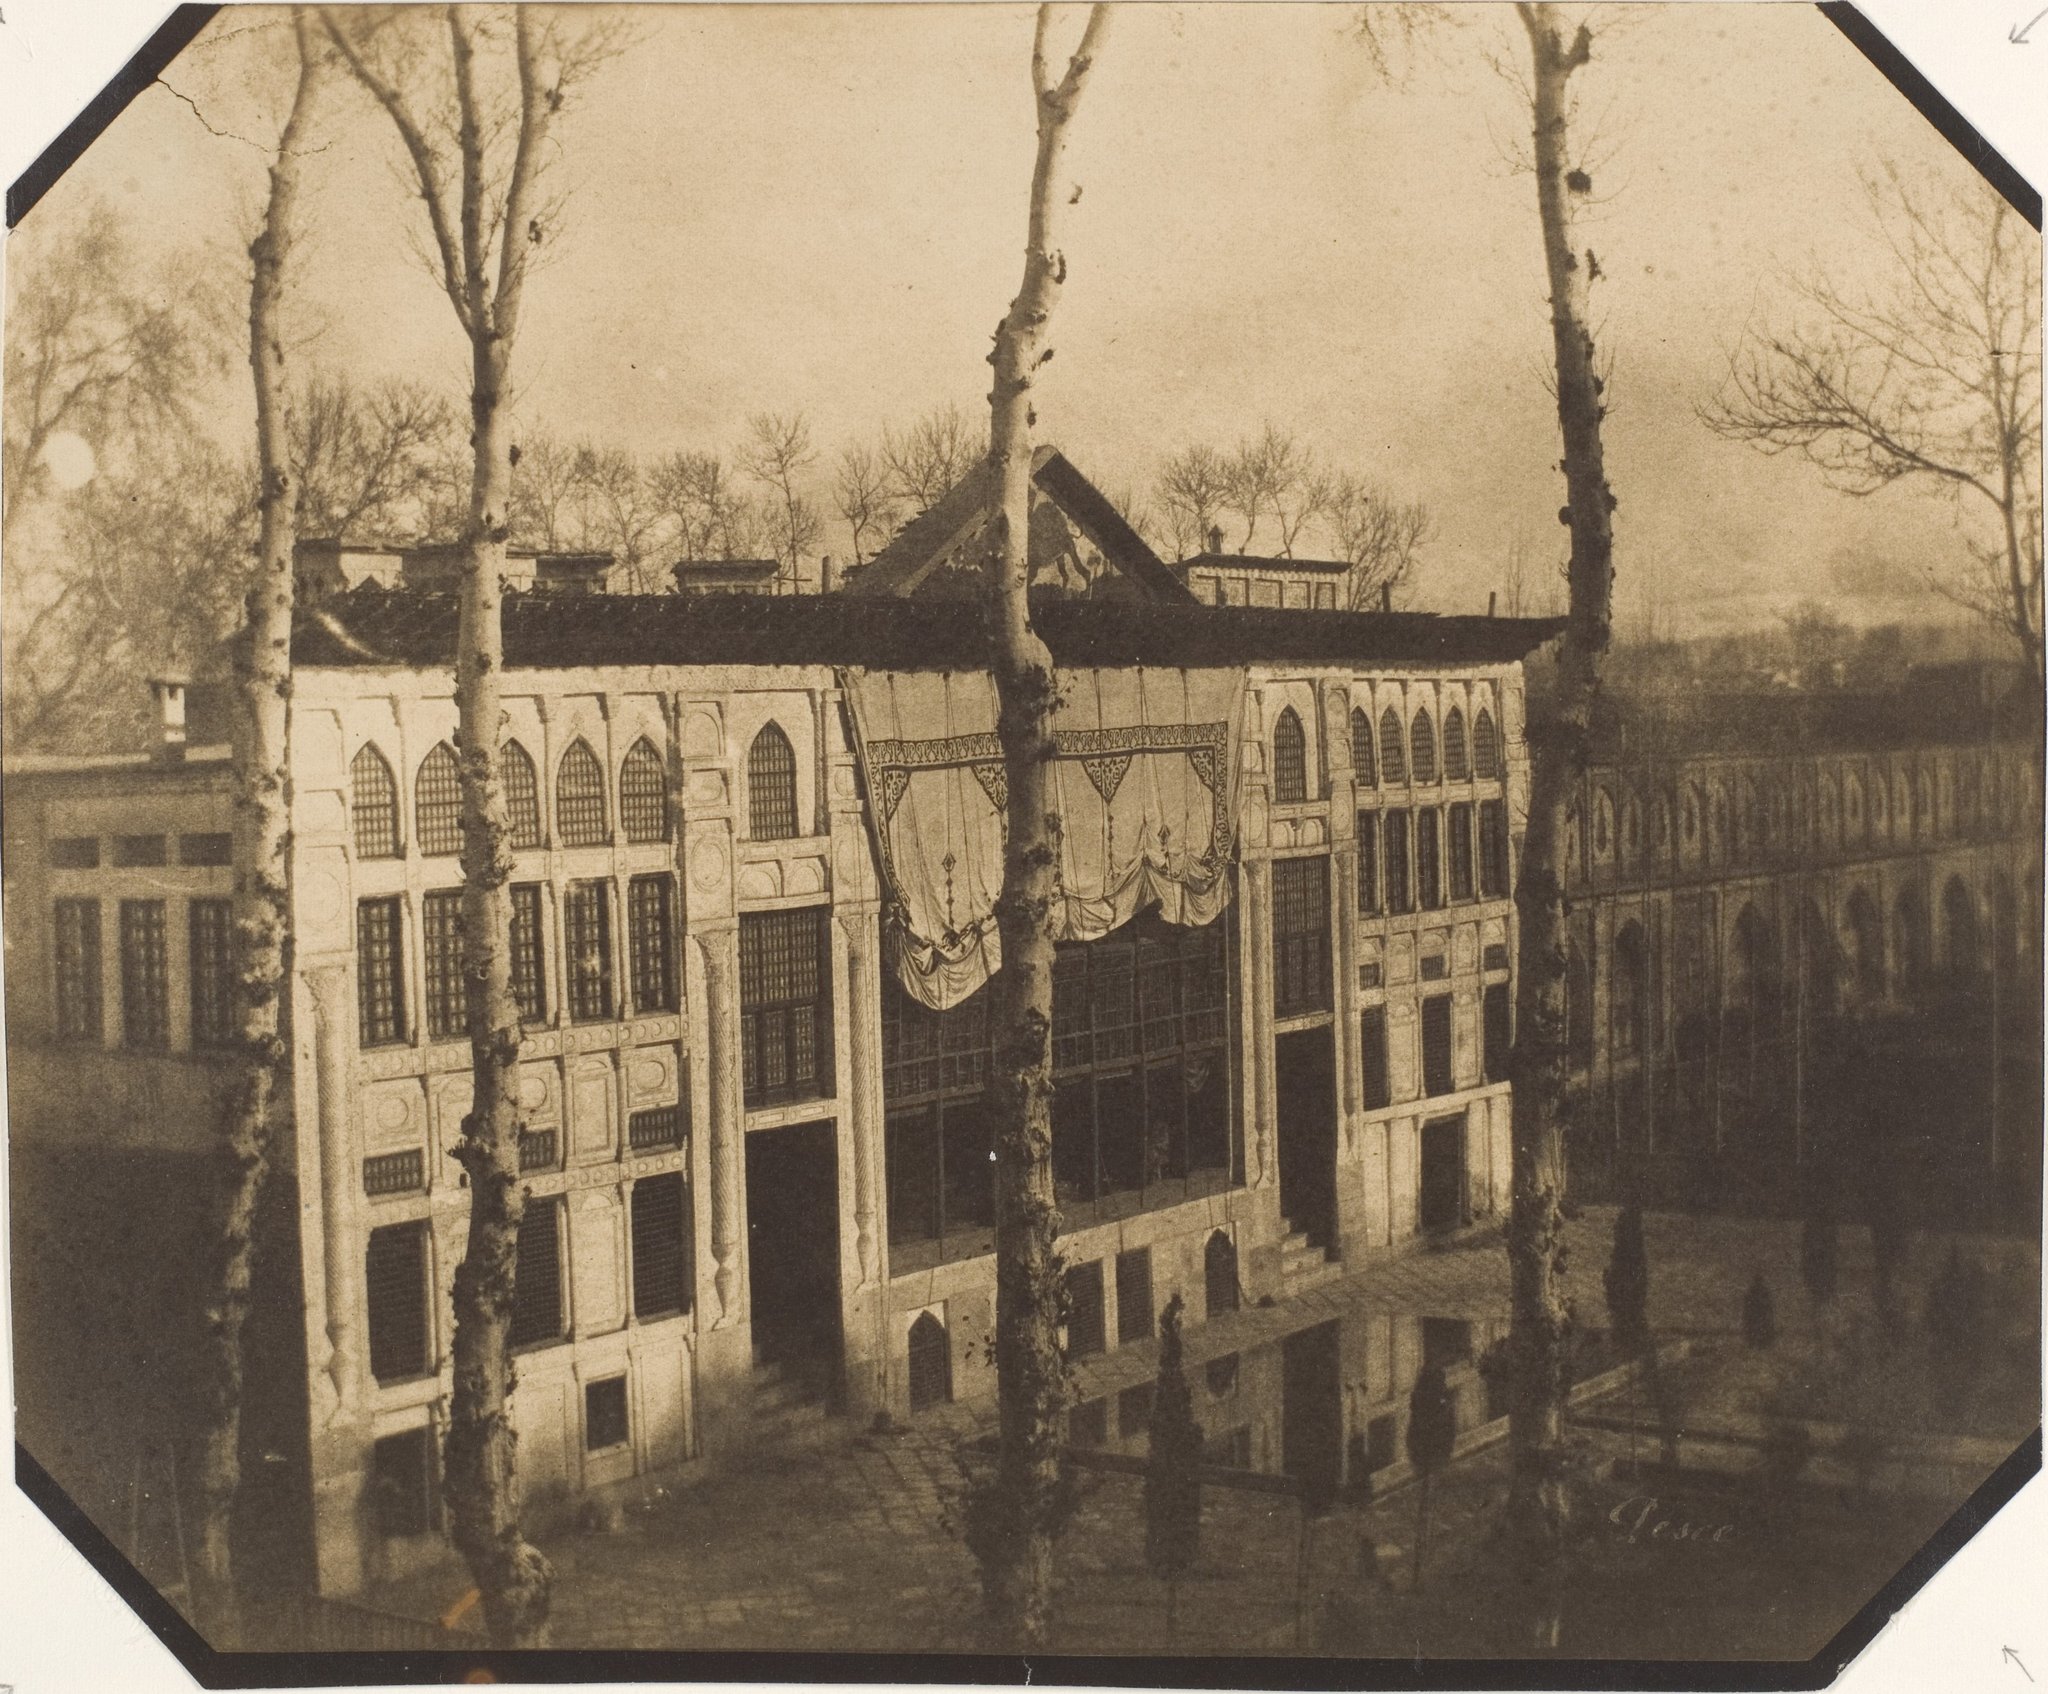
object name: photograph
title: [Palace of the Shah]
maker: luigi pesce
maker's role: artist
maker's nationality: italian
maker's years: 1818-1891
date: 1850-1859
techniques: albumen silver print, paper negative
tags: architecture,palaces